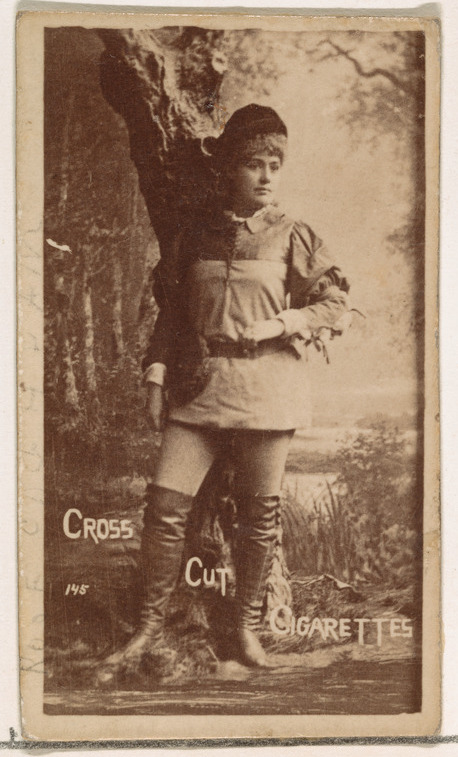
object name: print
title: Card Number 145, from the Actors and Actresses series (N145-1) issued by Duke Sons & Co. to promote Cross Cut Cigarettes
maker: w. duke, sons & co.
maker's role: publisher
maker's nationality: american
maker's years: 1870-1920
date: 1880-1889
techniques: albumen silver print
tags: portraits,women,actresses